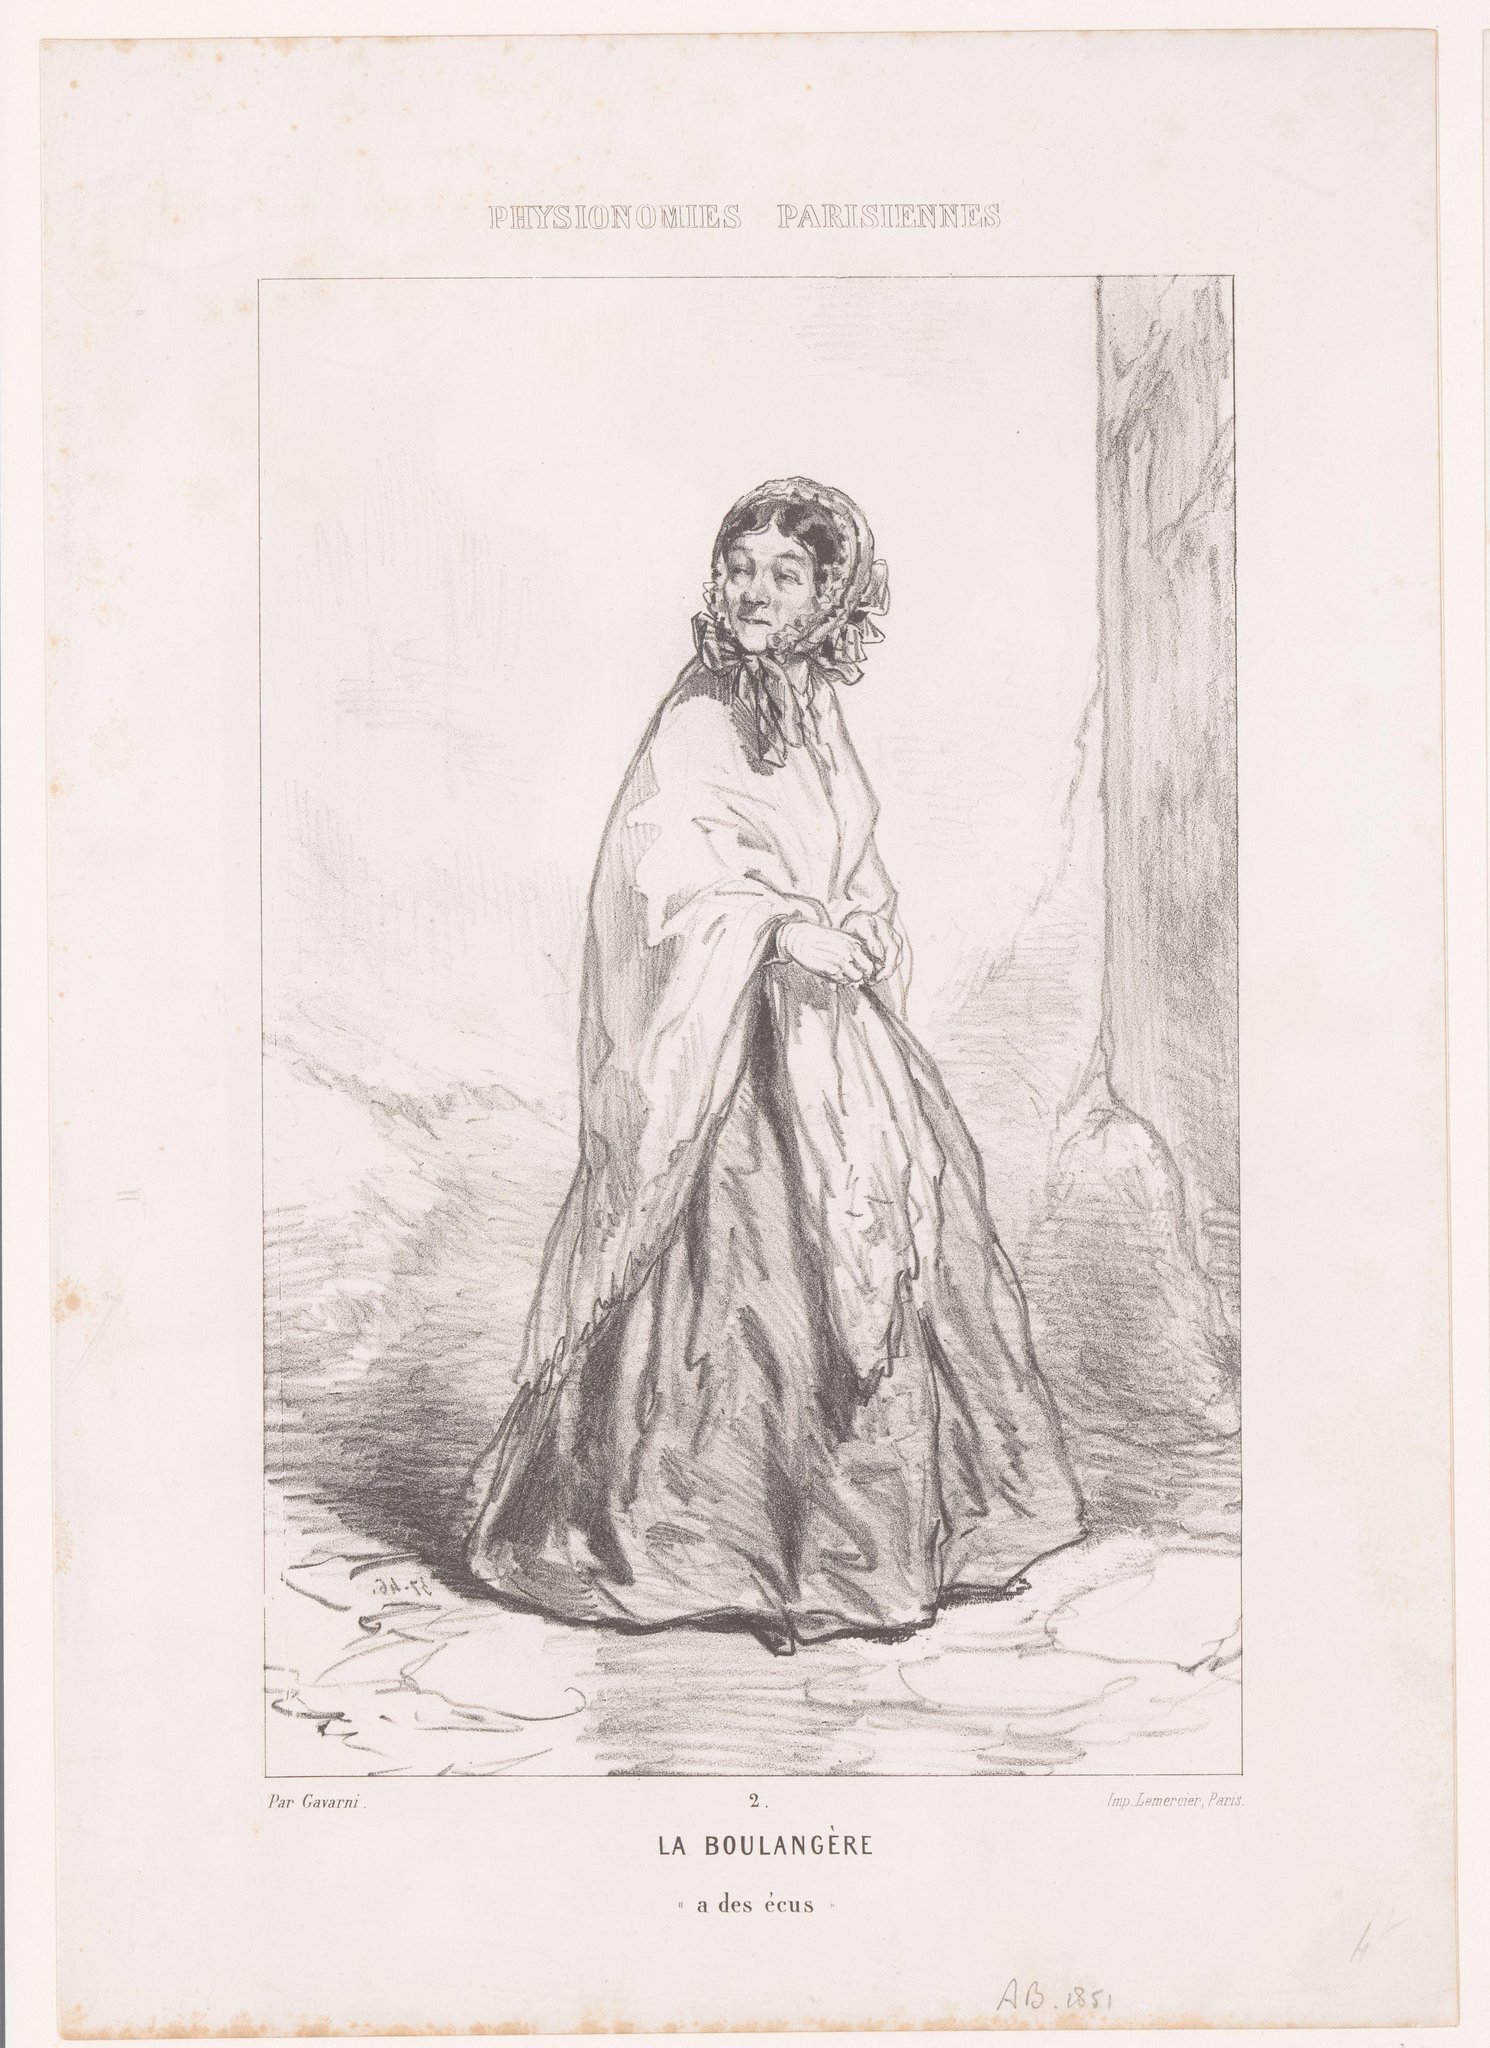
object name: cartoon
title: Bakkersvrouw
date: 1857-1858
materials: paper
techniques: lithograph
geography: paris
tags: baker, physiognomy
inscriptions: collector's mark: Lugt 2228a